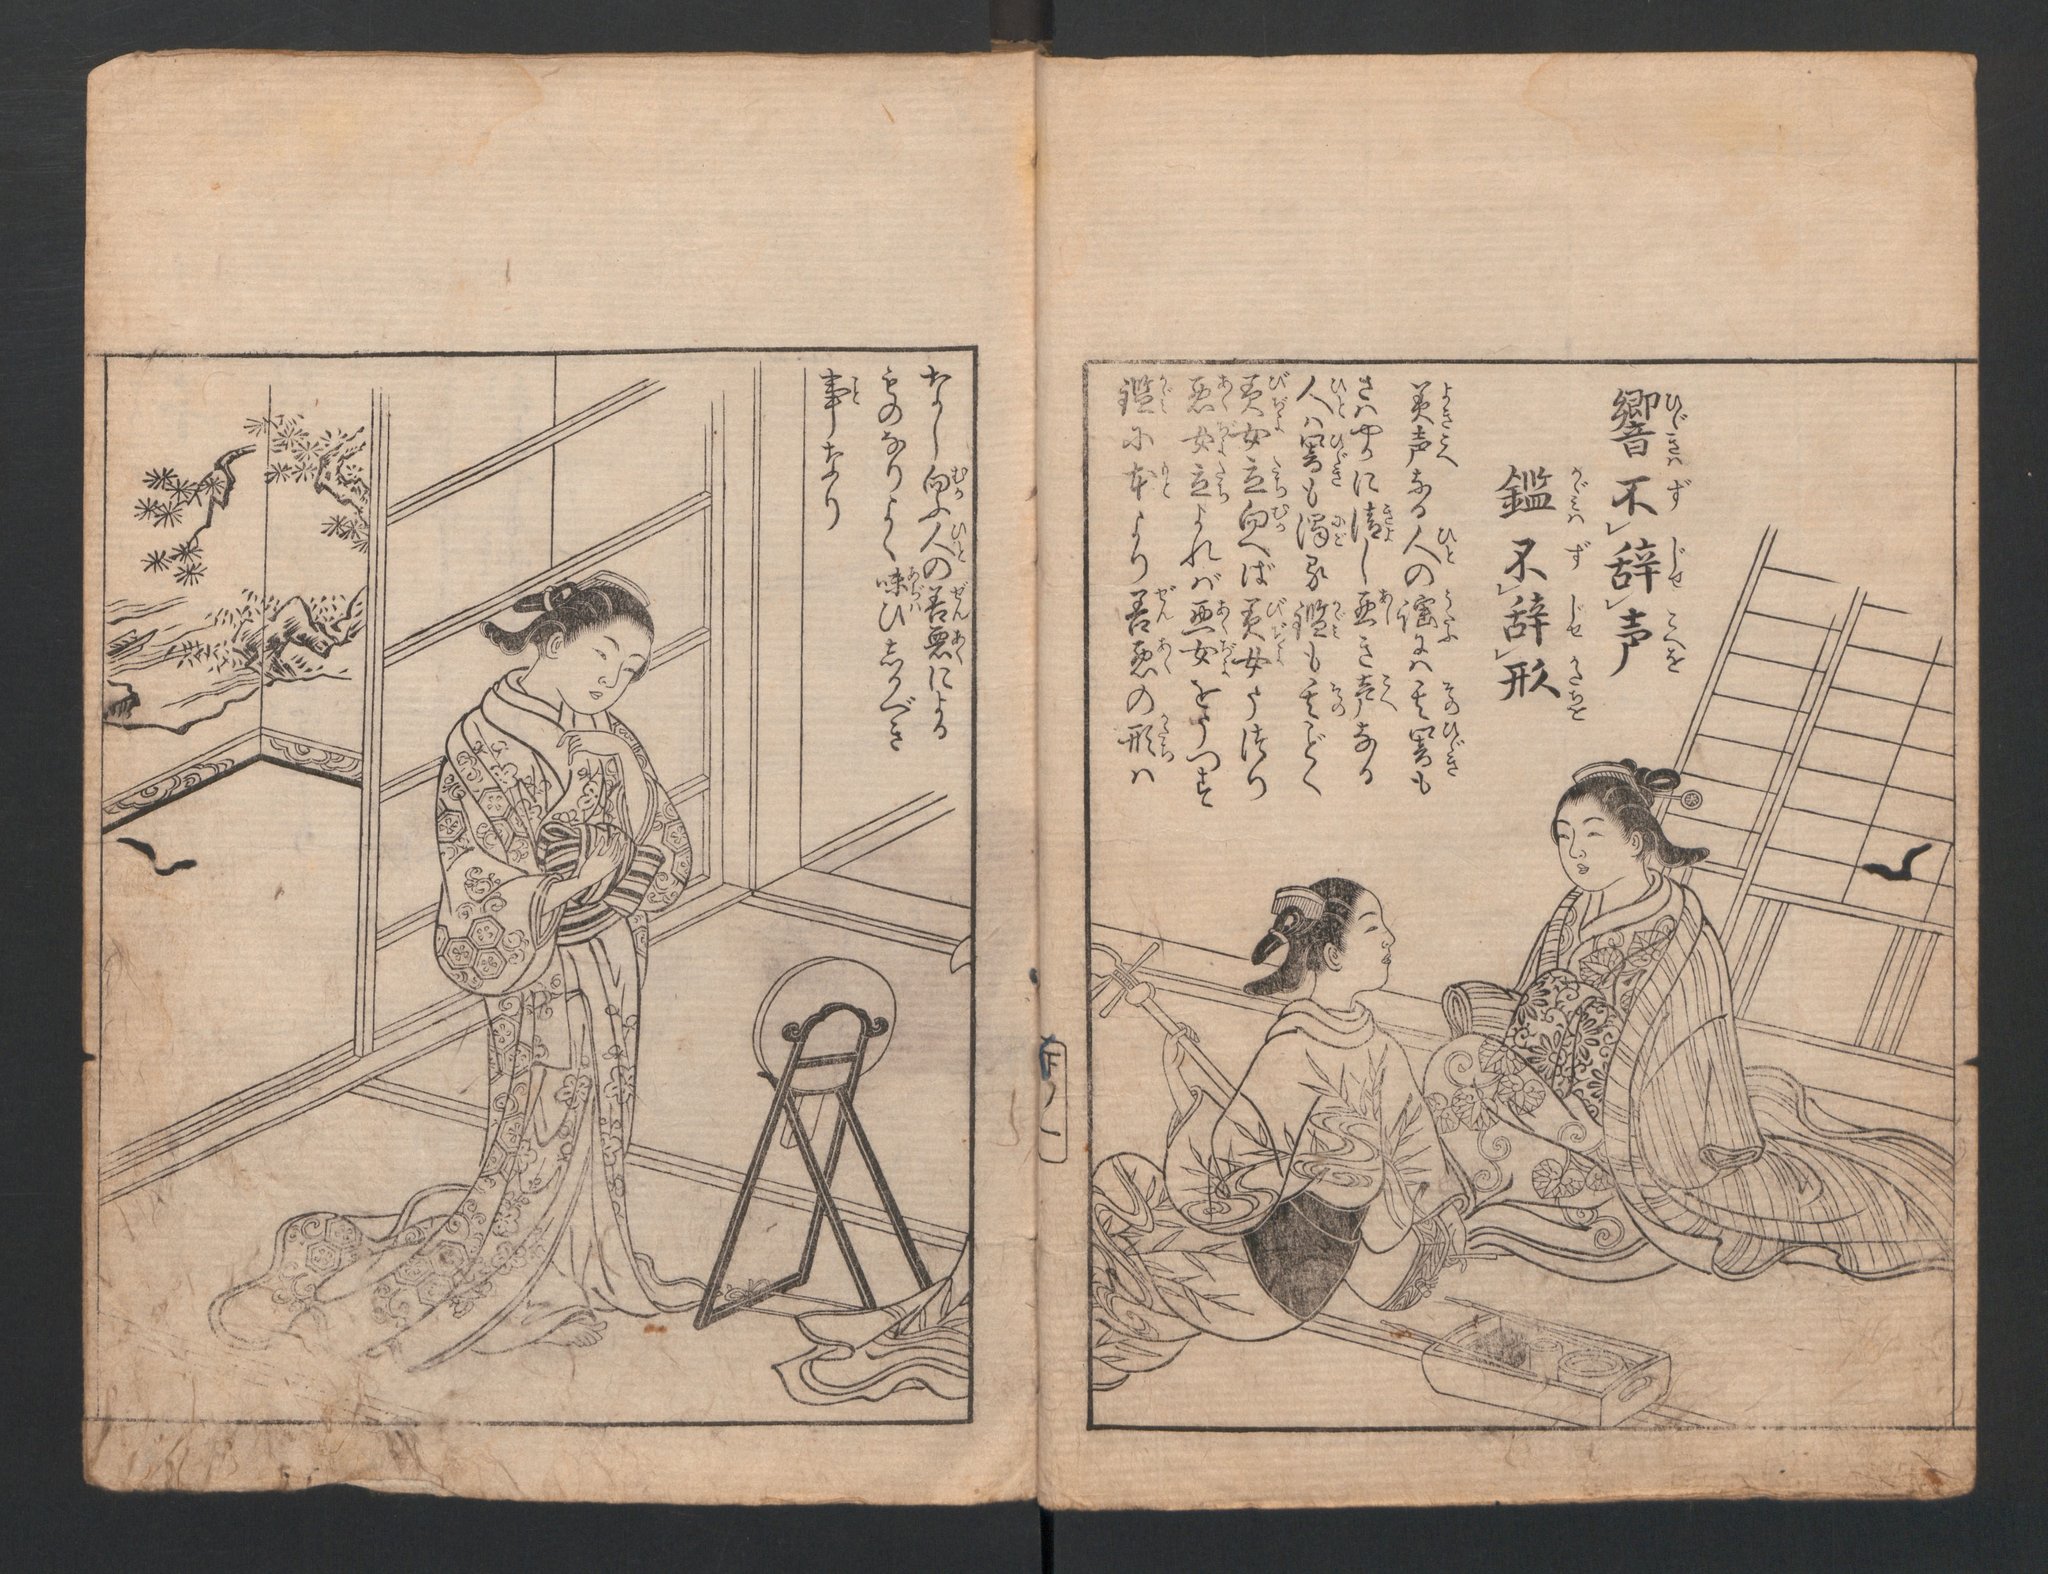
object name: illustrated book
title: Illustrated Proverbs, The Illustrated Lives of Women (Ehon Mitsuwagusa) 絵本三津輪草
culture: japanese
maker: nishikawa sukenobu 西川祐信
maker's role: artist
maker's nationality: japanese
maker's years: 1671-1750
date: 1741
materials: ink, paper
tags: women